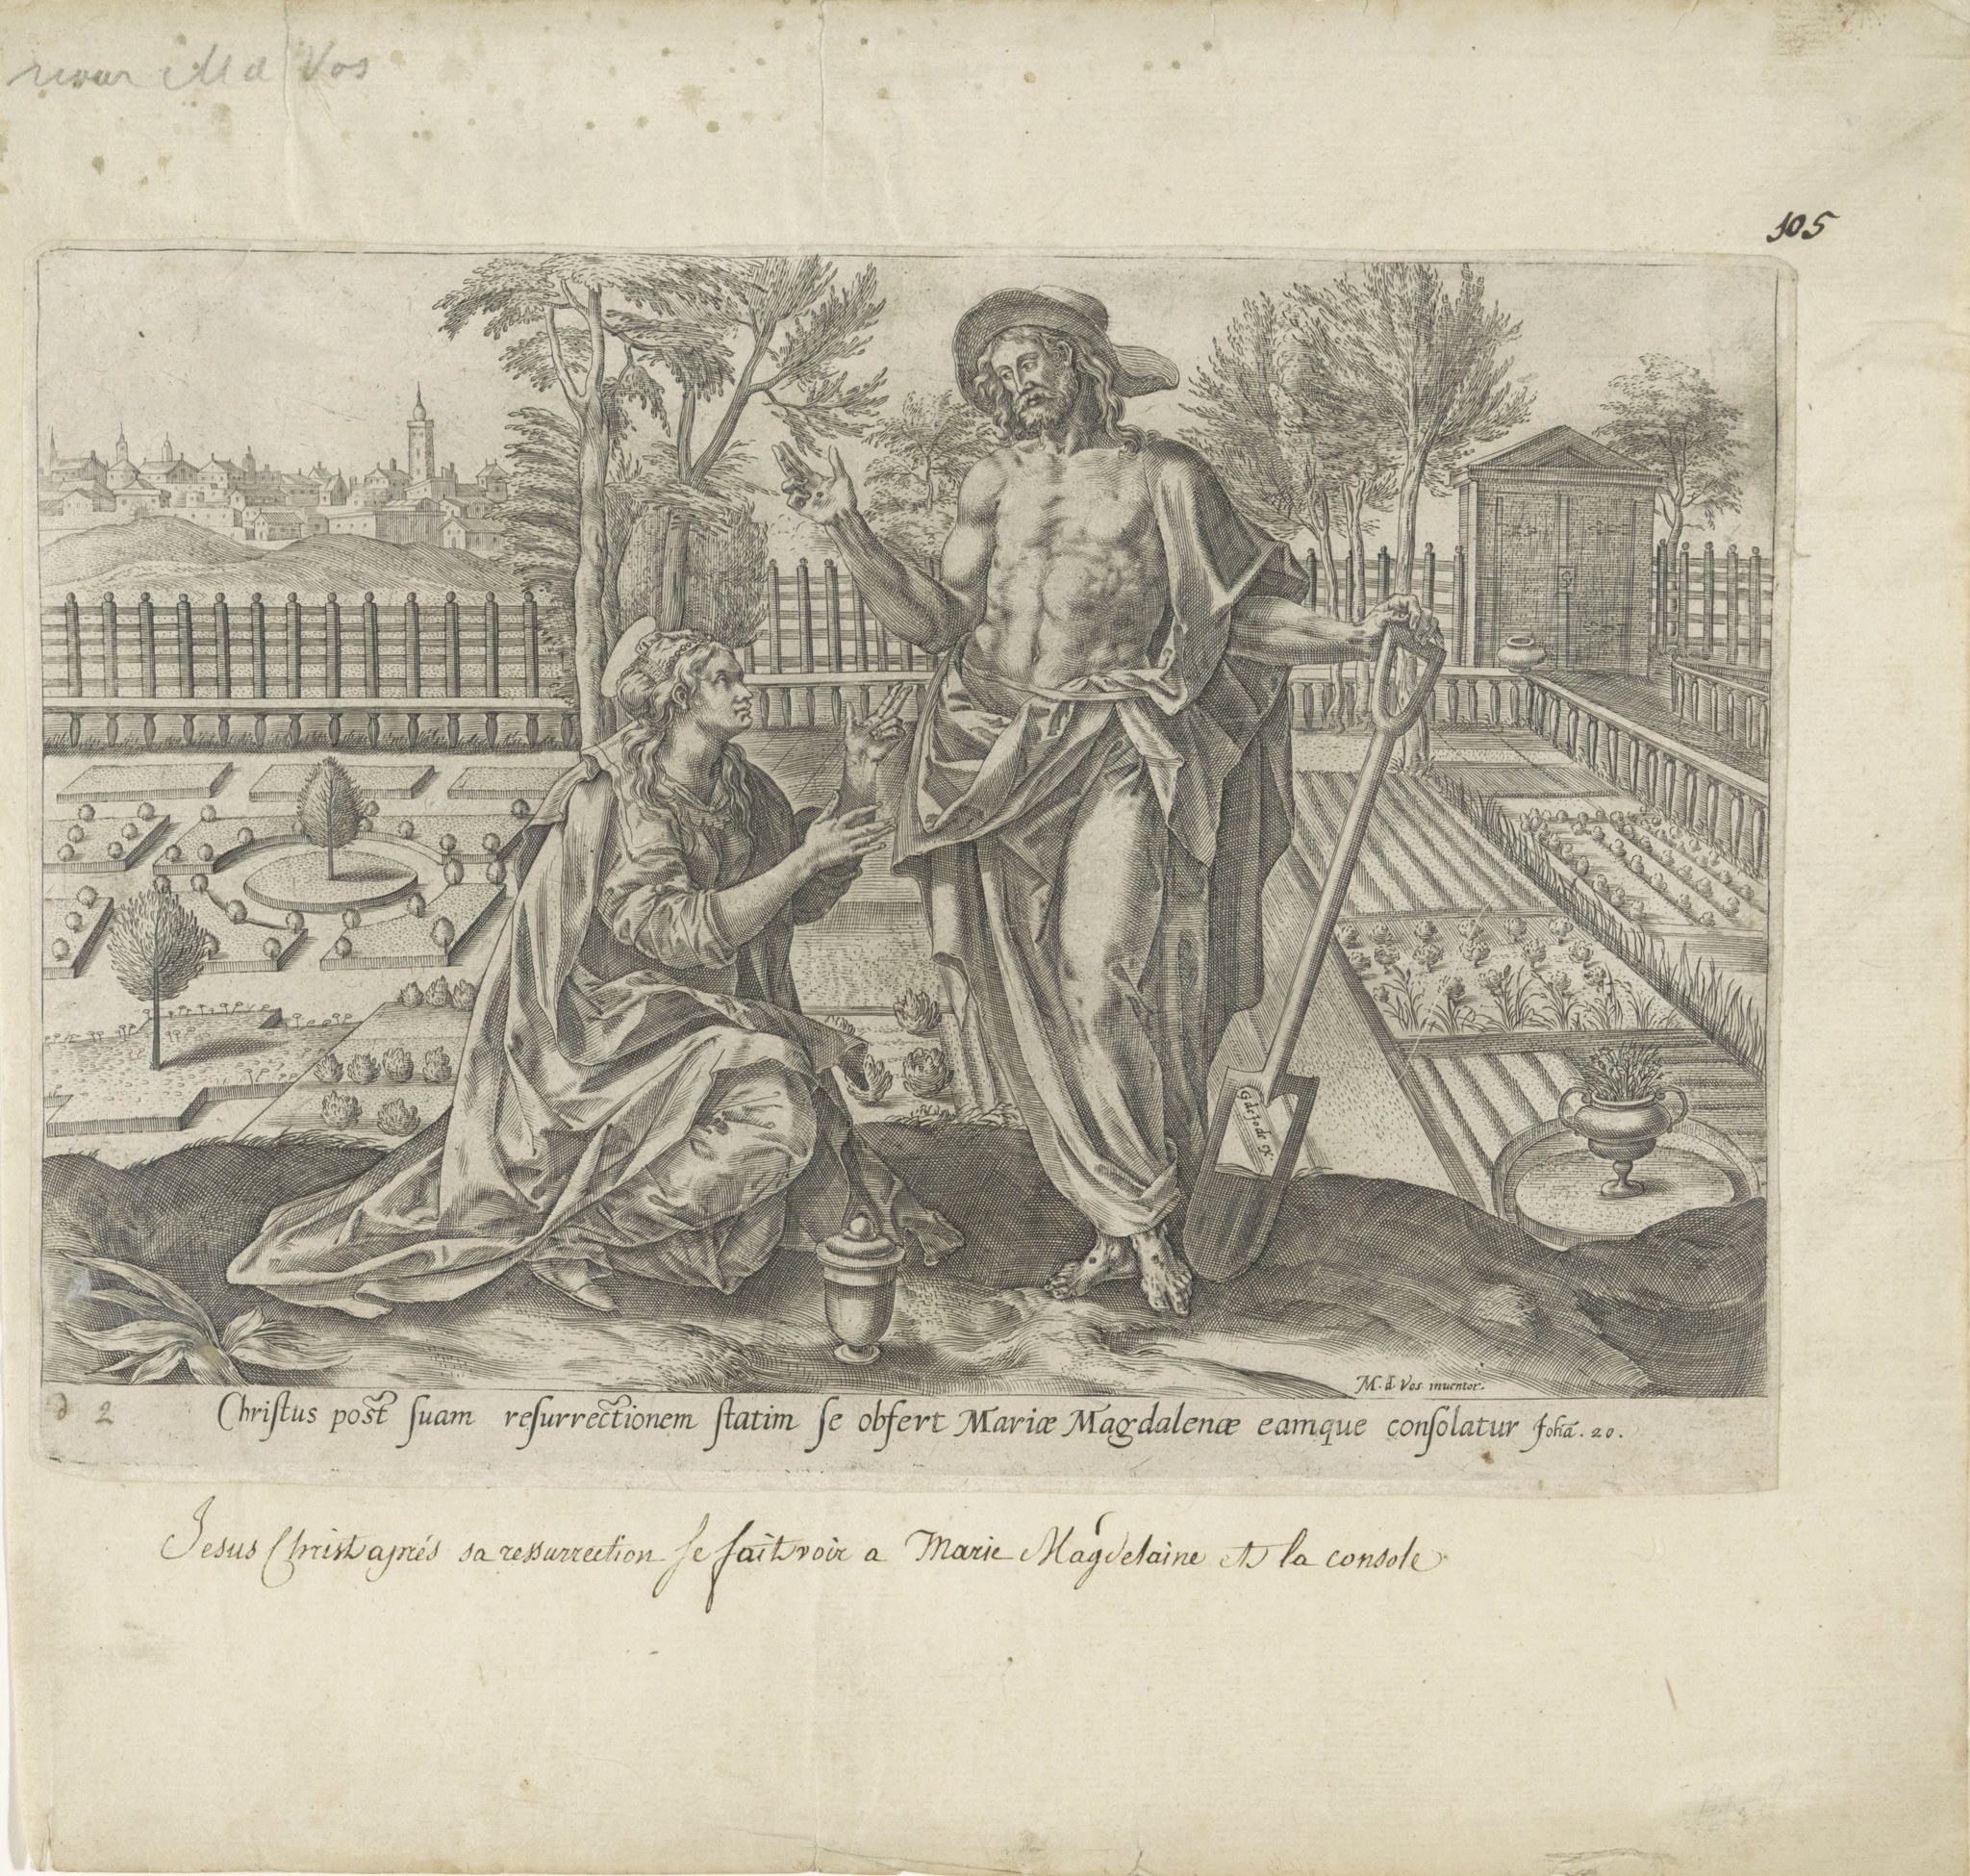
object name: print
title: Thesaurus sacrarum historiarum veteris testamenti (...)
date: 1585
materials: paper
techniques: engraving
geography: antwerp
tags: mary magdalene kneeling before christ, who is usually represented as a gardener with a hoe and/or a spade; 'noli me tangere'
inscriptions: number: ‘105’, inscription: ‘Jesus Christ apres sa resurrection de fait voir a Marie Magdalaine et la console’, collector's mark: Lugt 2228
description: Maria Magdalena herkent de opgestane Christus, nadat ze hem voor tuinman had aangezien, en knielt voor hem. Christus is gekleed als tuinman. Hij zegt haar hem niet vast te houden. Onder de voorstelling een verwijzing in het Latijn naar de Bijbeltekst in Joh. 20.